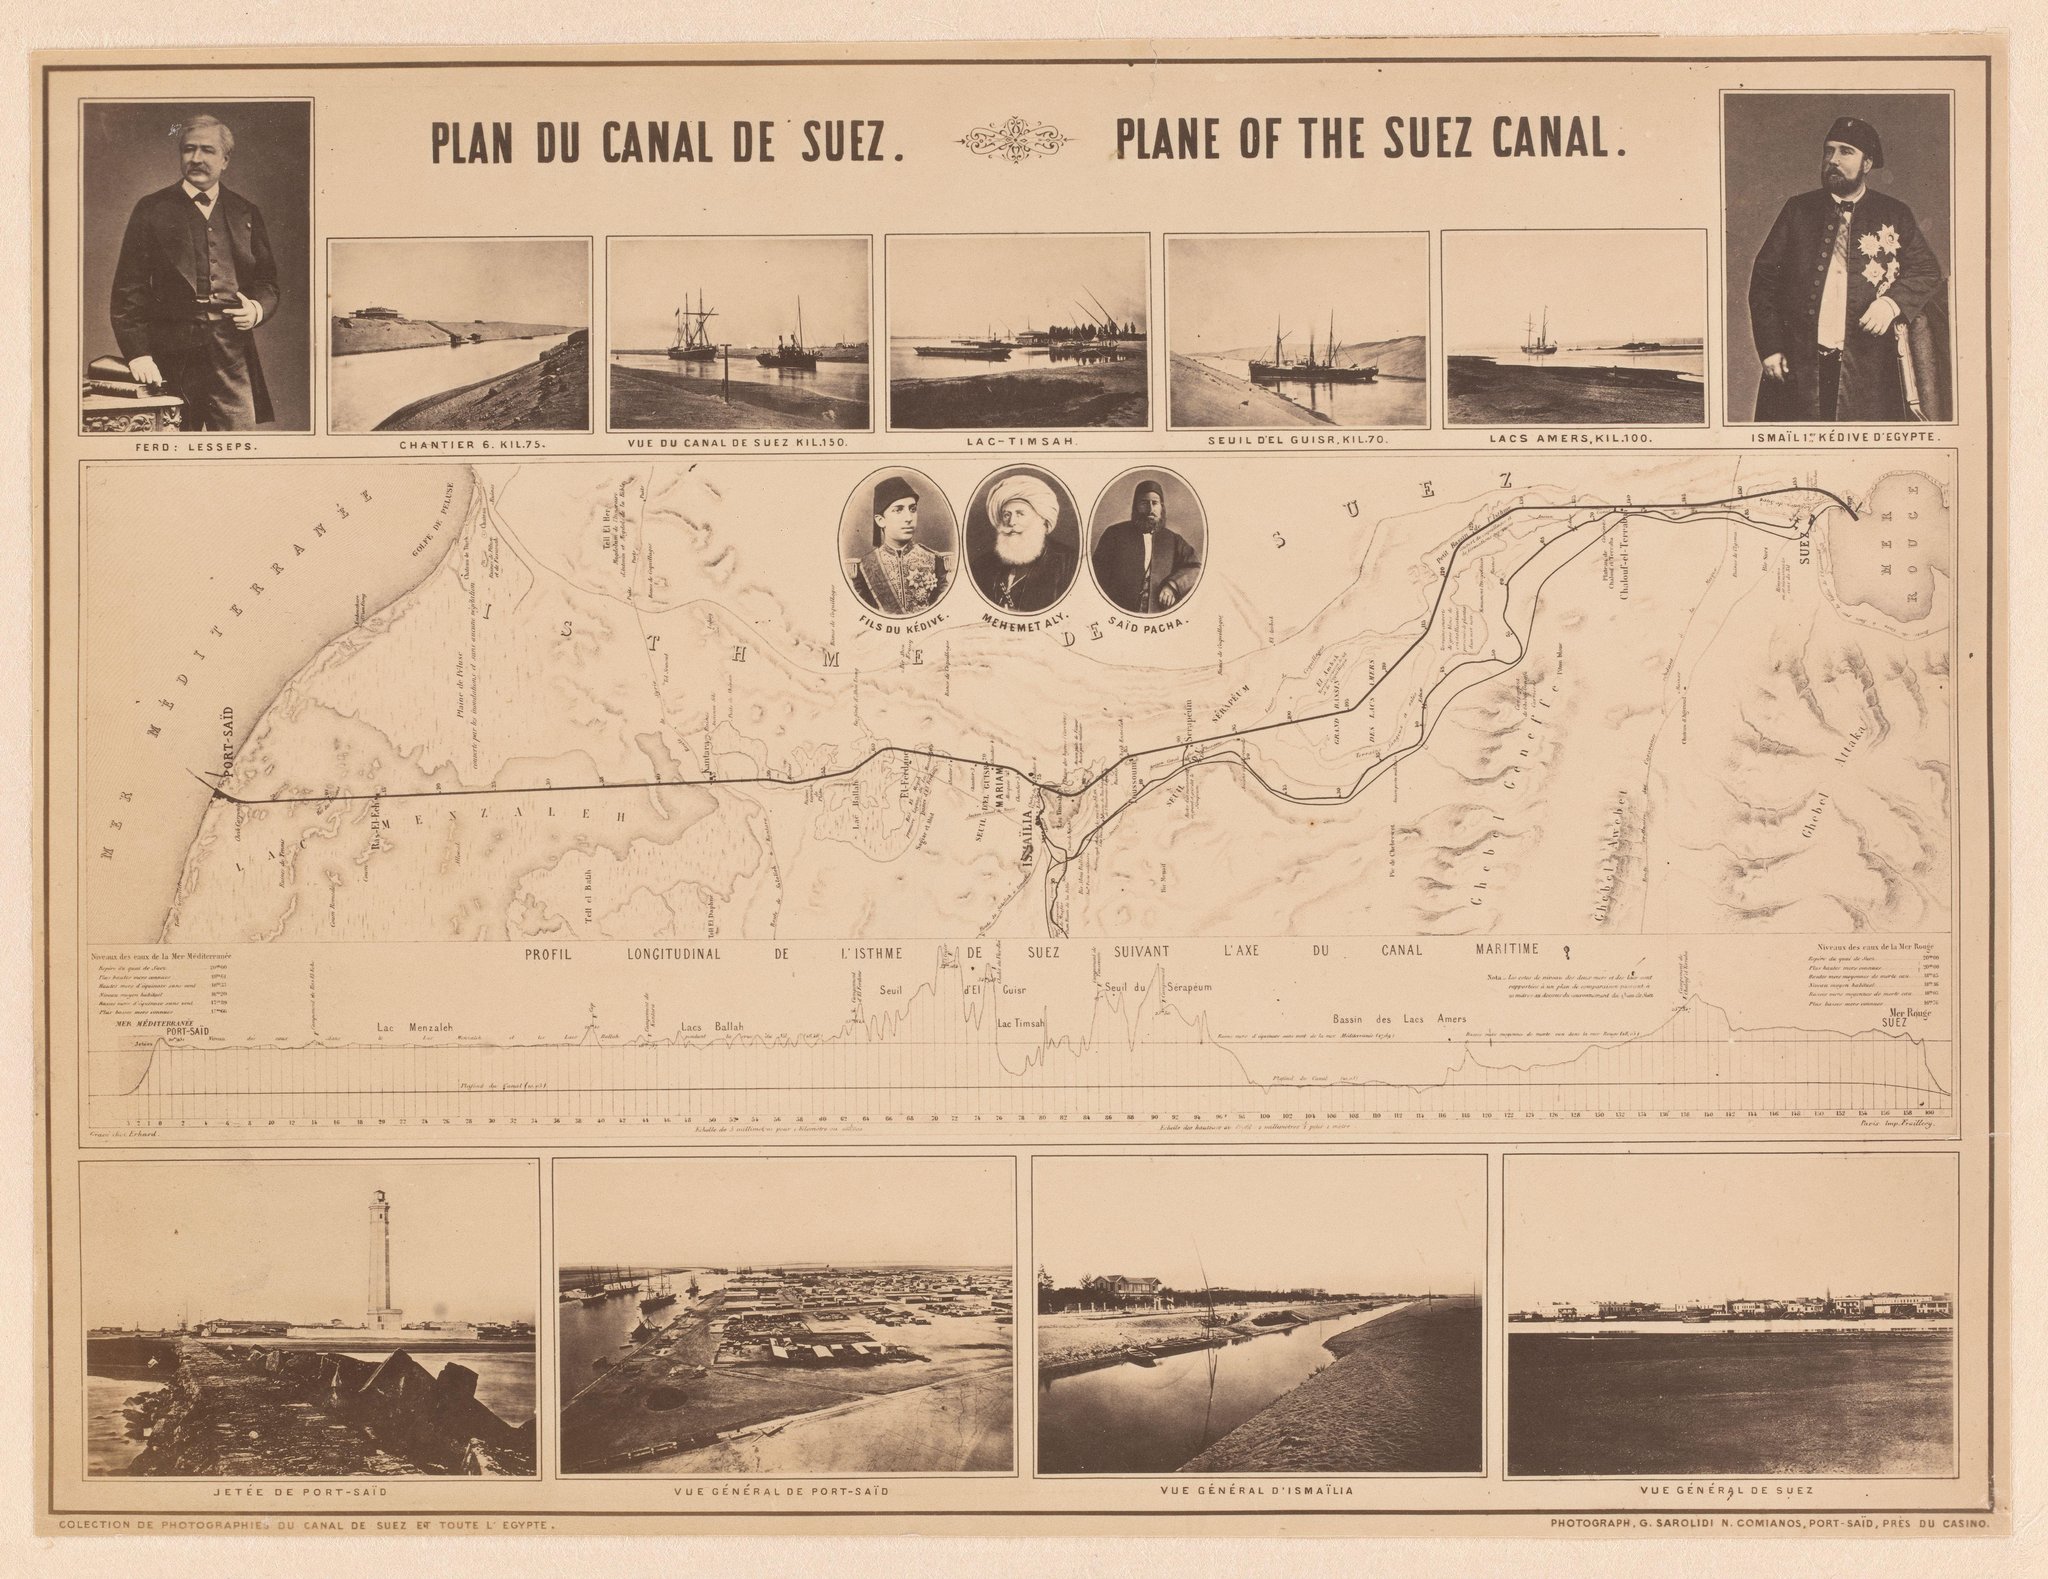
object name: photograph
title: Plan de Canal de Suez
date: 1869-1875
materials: paper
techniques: albumen print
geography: port said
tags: suezkanaal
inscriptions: number: ‘R14/2 [doorgestrepen]’, number: ‘19’, number: ‘BD.119 [doorgestrepen]’